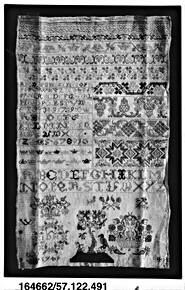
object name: sampler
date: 1749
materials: linen, silk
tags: birds,trees